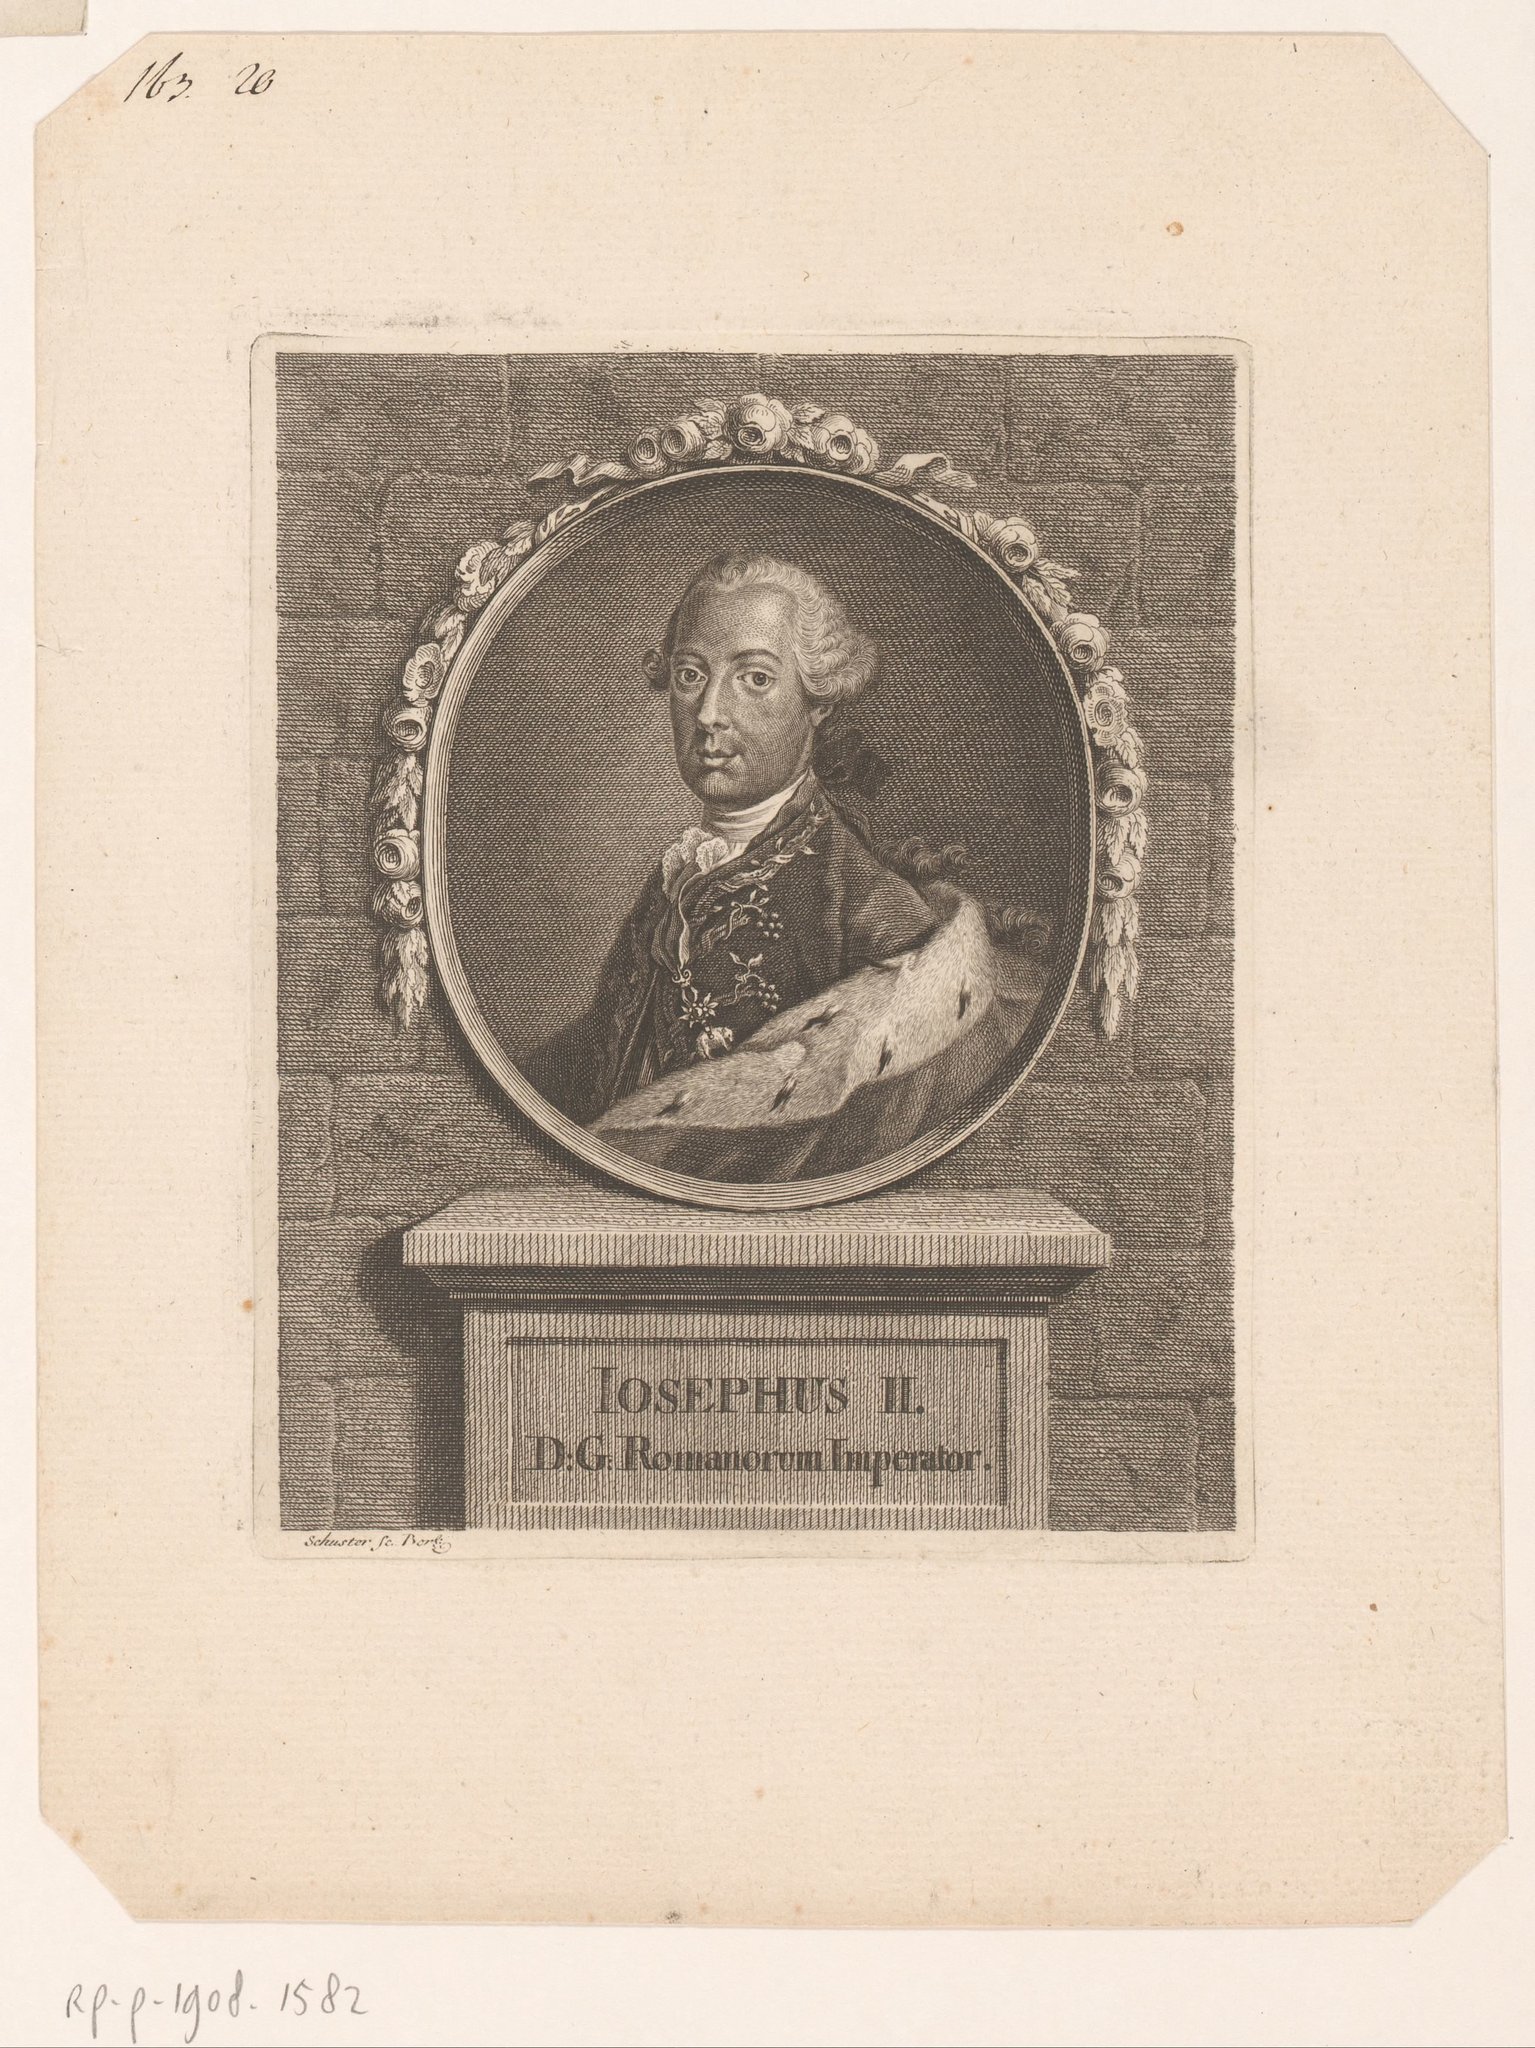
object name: print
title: Portret van Jozef II, Duits keizer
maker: j.f. schuster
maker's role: print maker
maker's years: 1720-1796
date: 1765-1796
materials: paper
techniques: engraving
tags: vienna, jozef ii (duits keizer), historical persons, knighthood order of the golden fleece - insignia of a knighthood order, e.g.: badge, chain (with name of order)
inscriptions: collector's mark: Lugt 2228